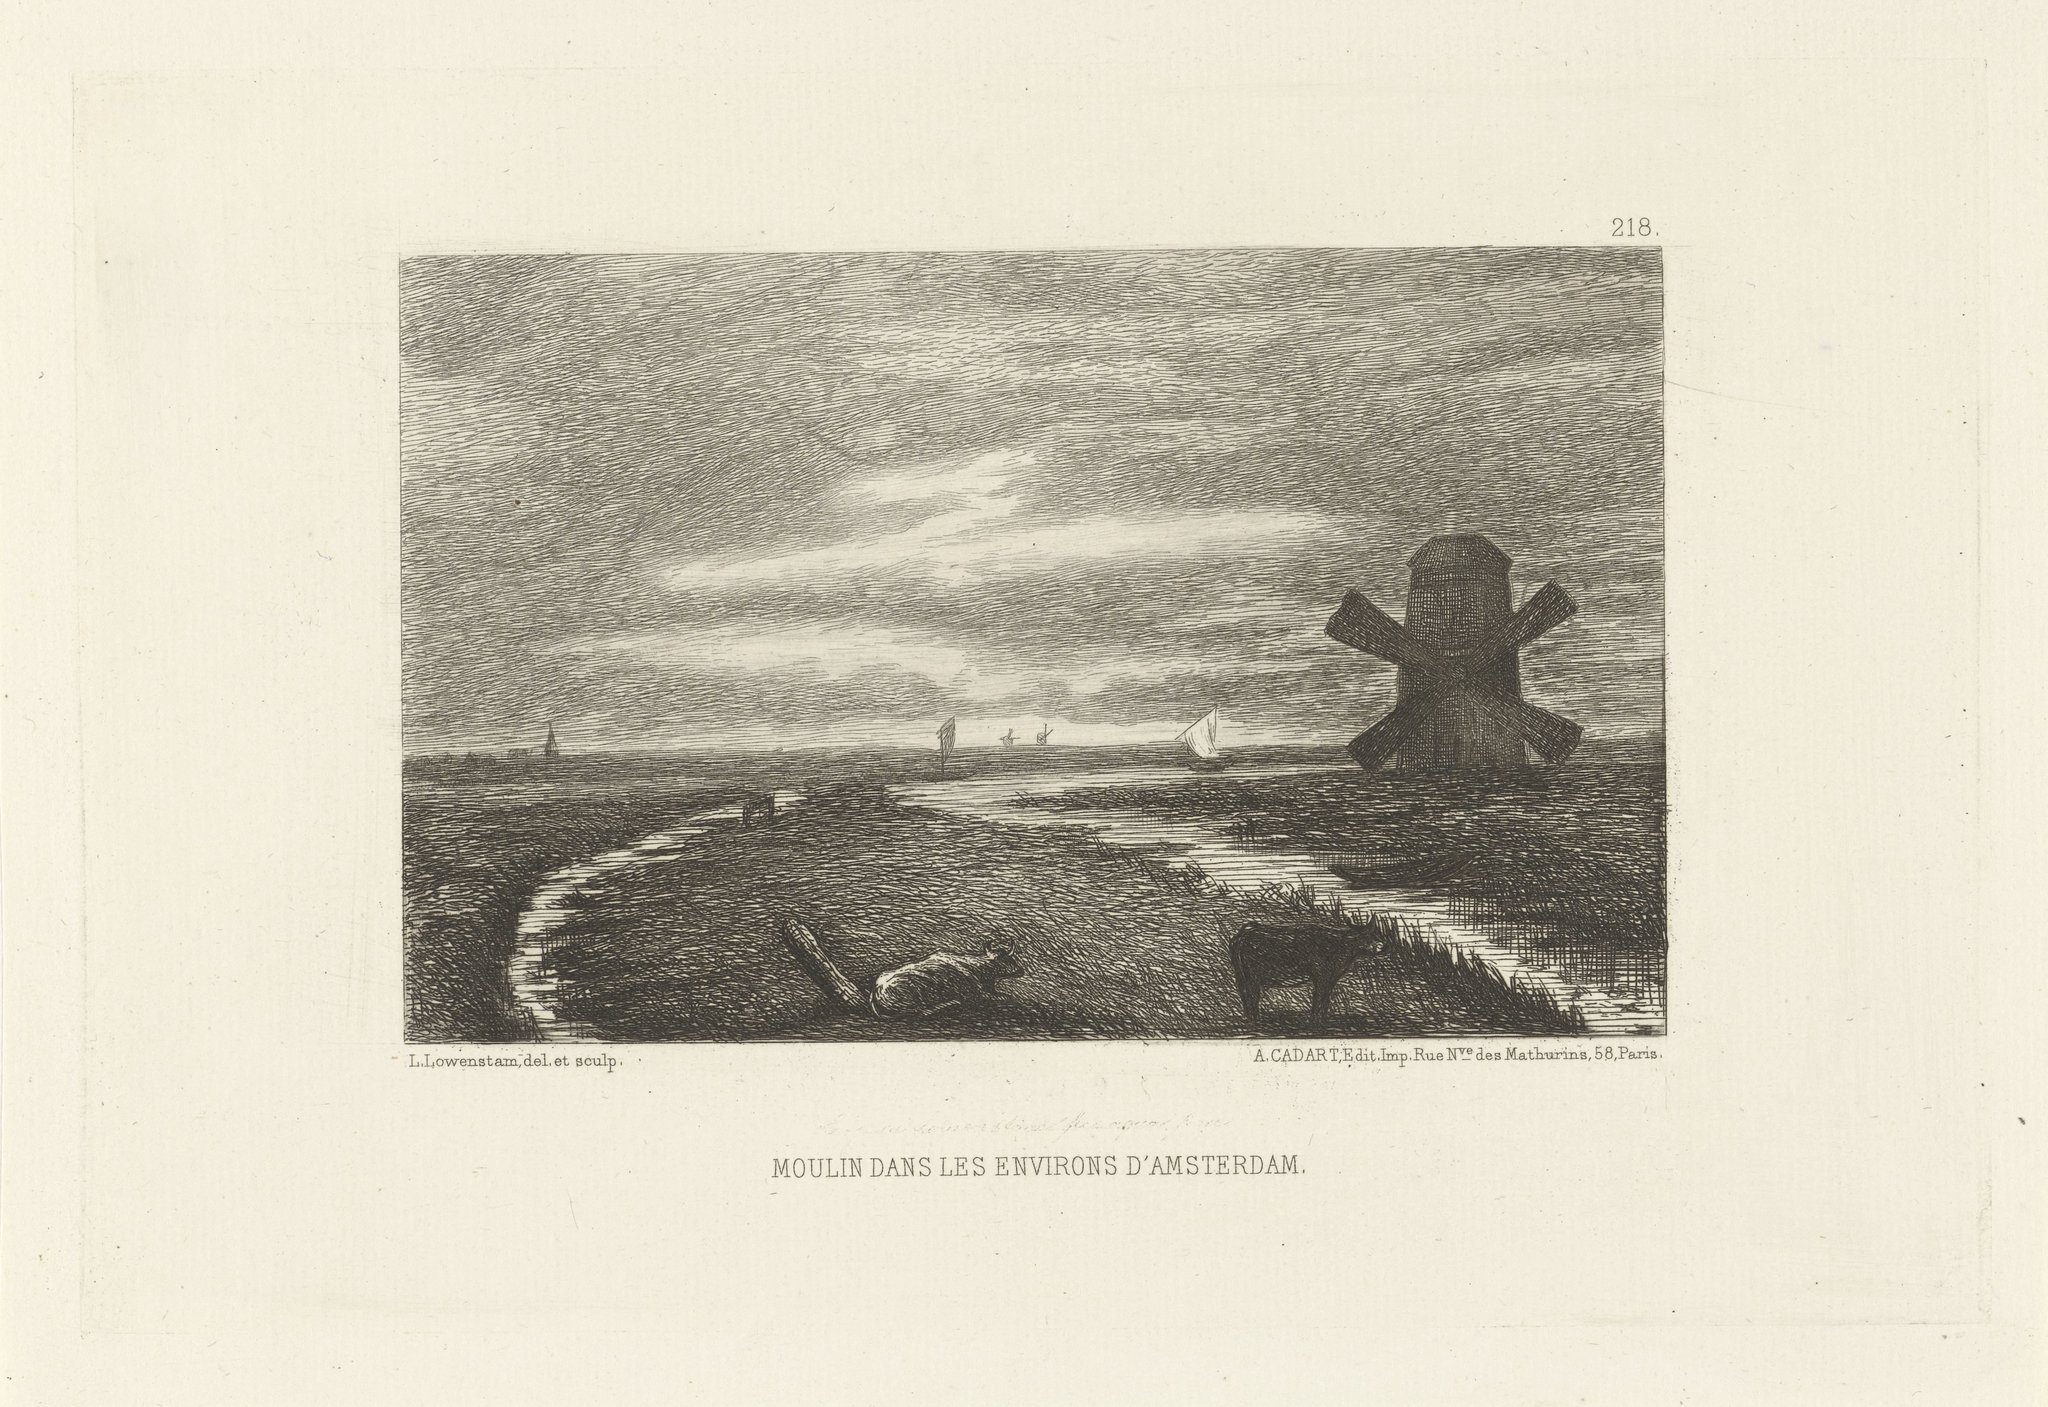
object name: print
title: Moulin Dans Les Environs D'Amsterdam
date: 1852-1875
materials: paper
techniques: etching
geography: paris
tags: windmill in landscape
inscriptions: collector's mark: Lugt 2228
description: Waterrijk landschap met een molen nabij Amsterdam. Op de voorgrond twee koeien in een weiland, in de verte varen boten. Prent rechtsboven genummerd: 218.